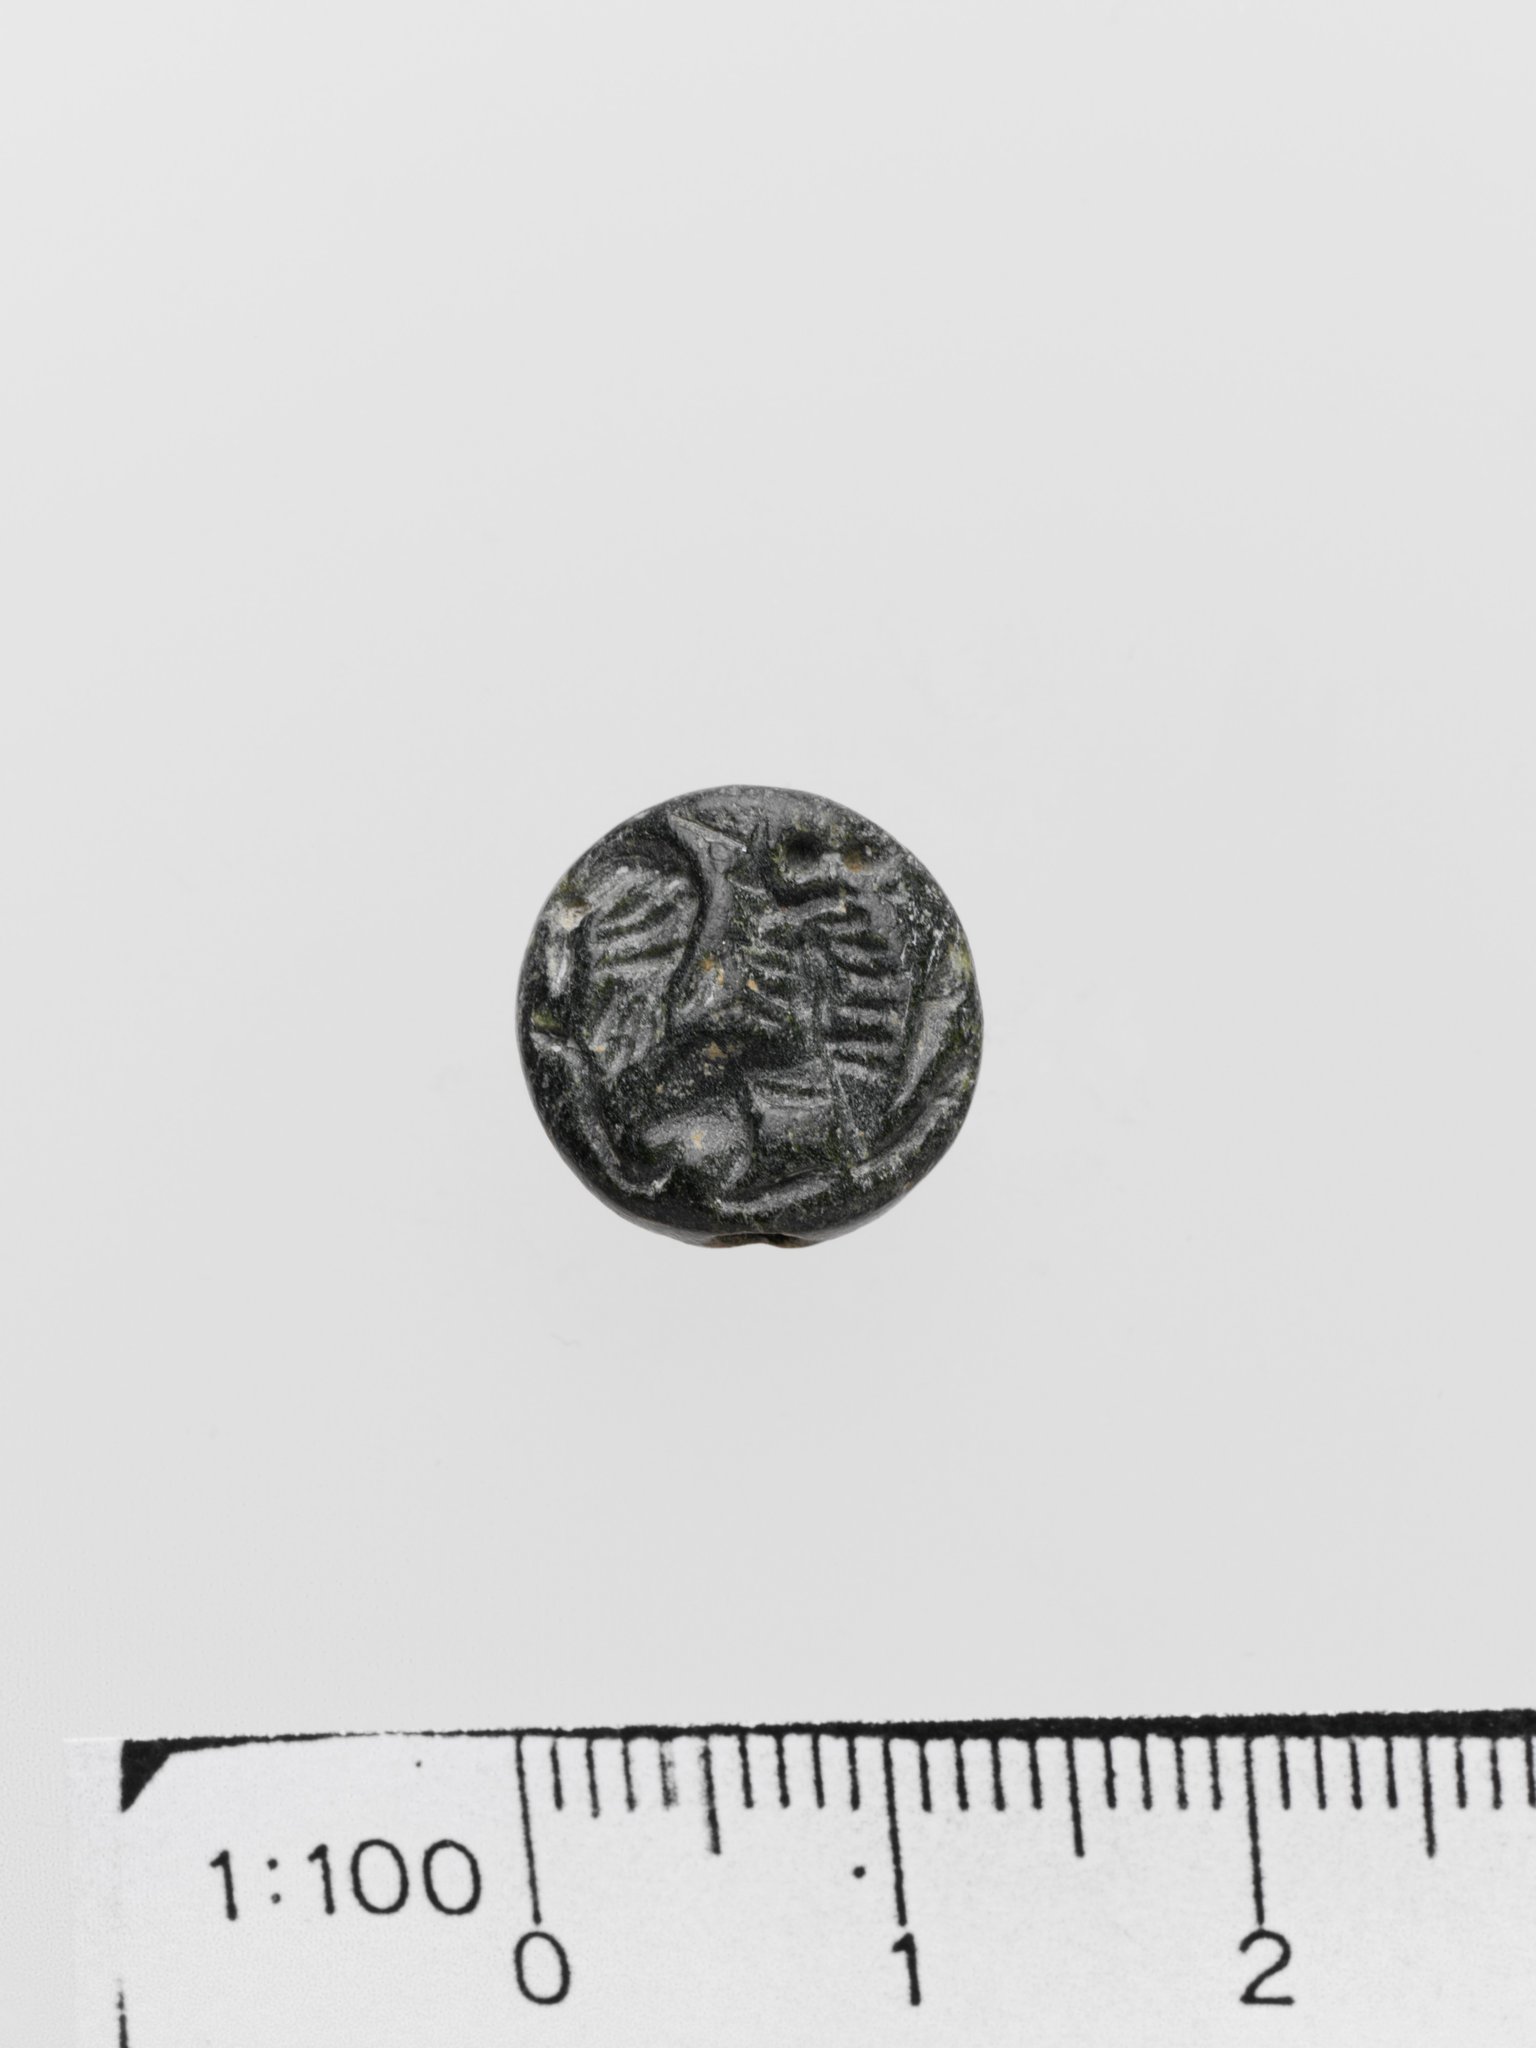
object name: seal, lentoid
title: Steatite lentoid seal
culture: minoan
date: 1400-1200 BCE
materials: stone